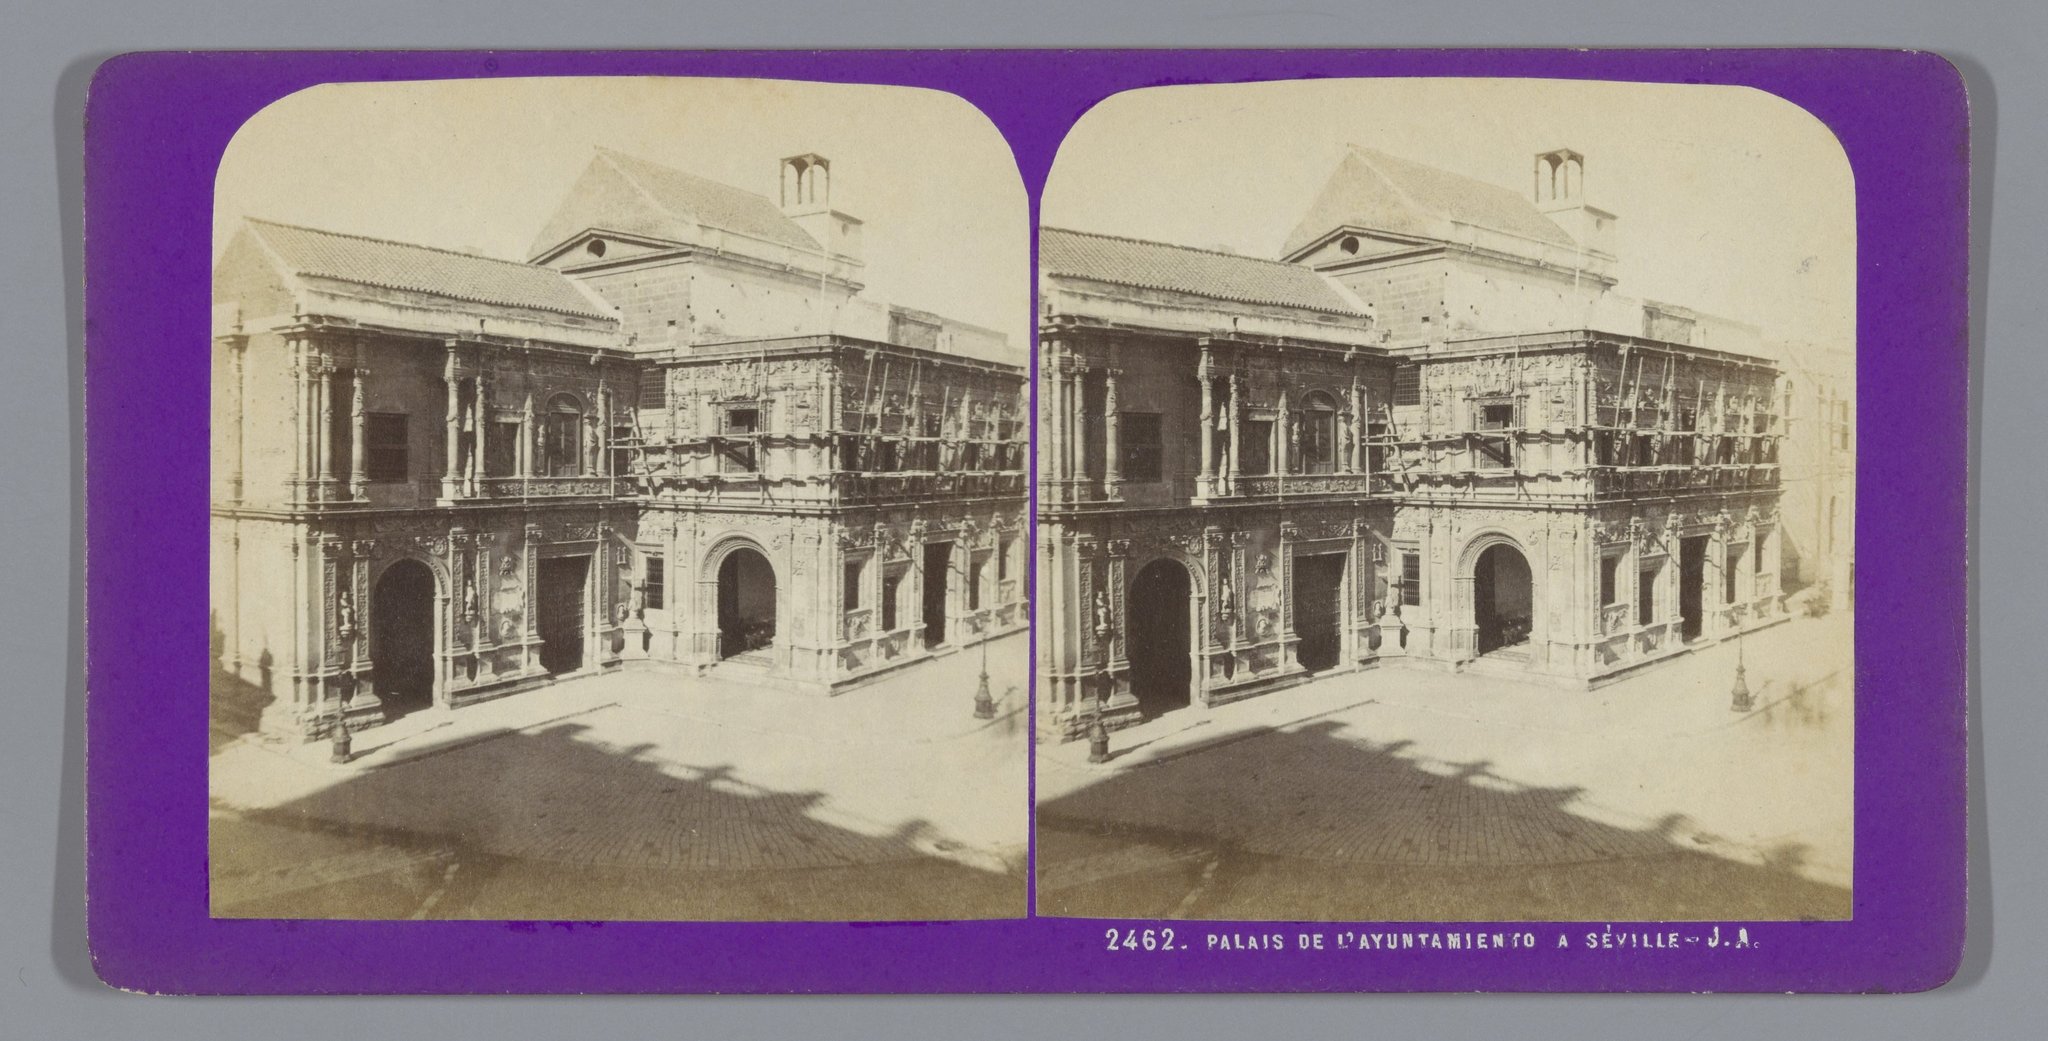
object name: stereograph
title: Gezicht op het Ayuntamiento in Sevilla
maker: jean andrieu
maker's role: fotograaf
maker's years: 1816-1872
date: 1862-1876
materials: cardboard, photographic support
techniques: albumen print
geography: sevilla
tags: townhall, sevilla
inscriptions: number: ‘2462.’